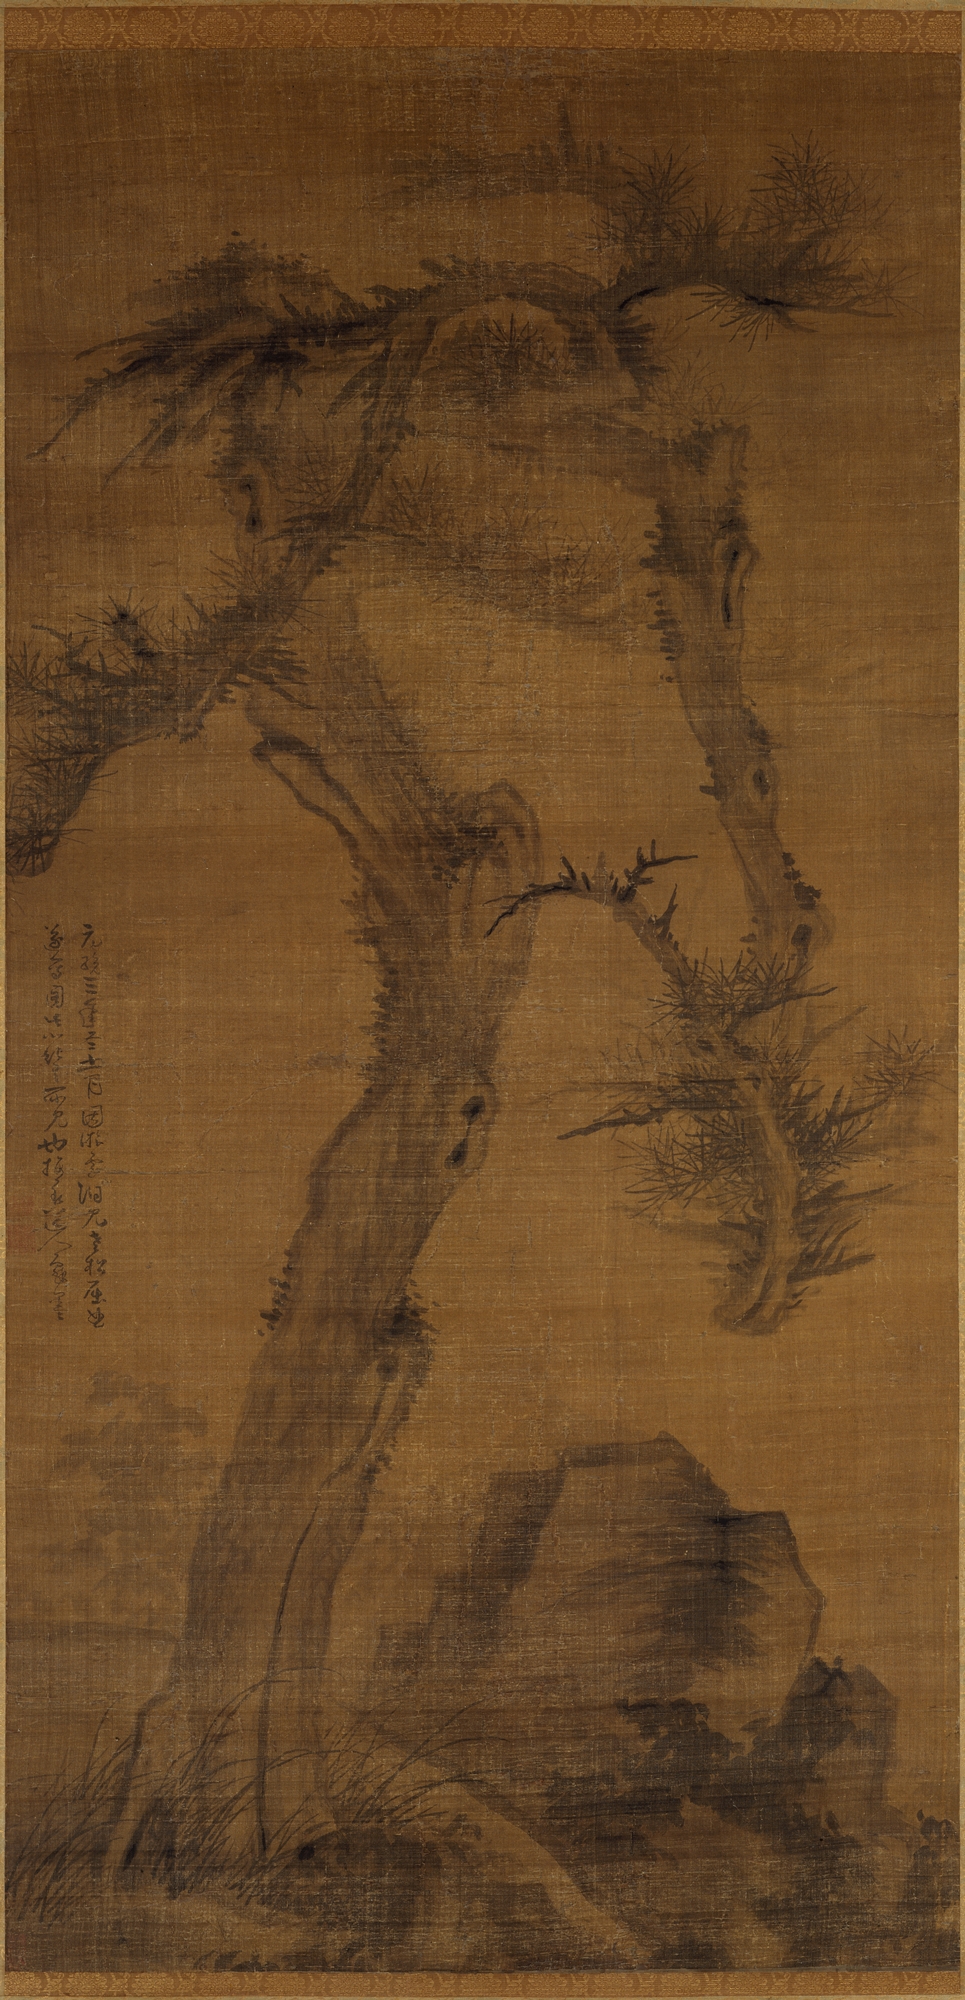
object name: hanging scroll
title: Crooked Pine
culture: chinese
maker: wu zhen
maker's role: artist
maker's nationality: chinese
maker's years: 1280-1354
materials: ink, silk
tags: trees